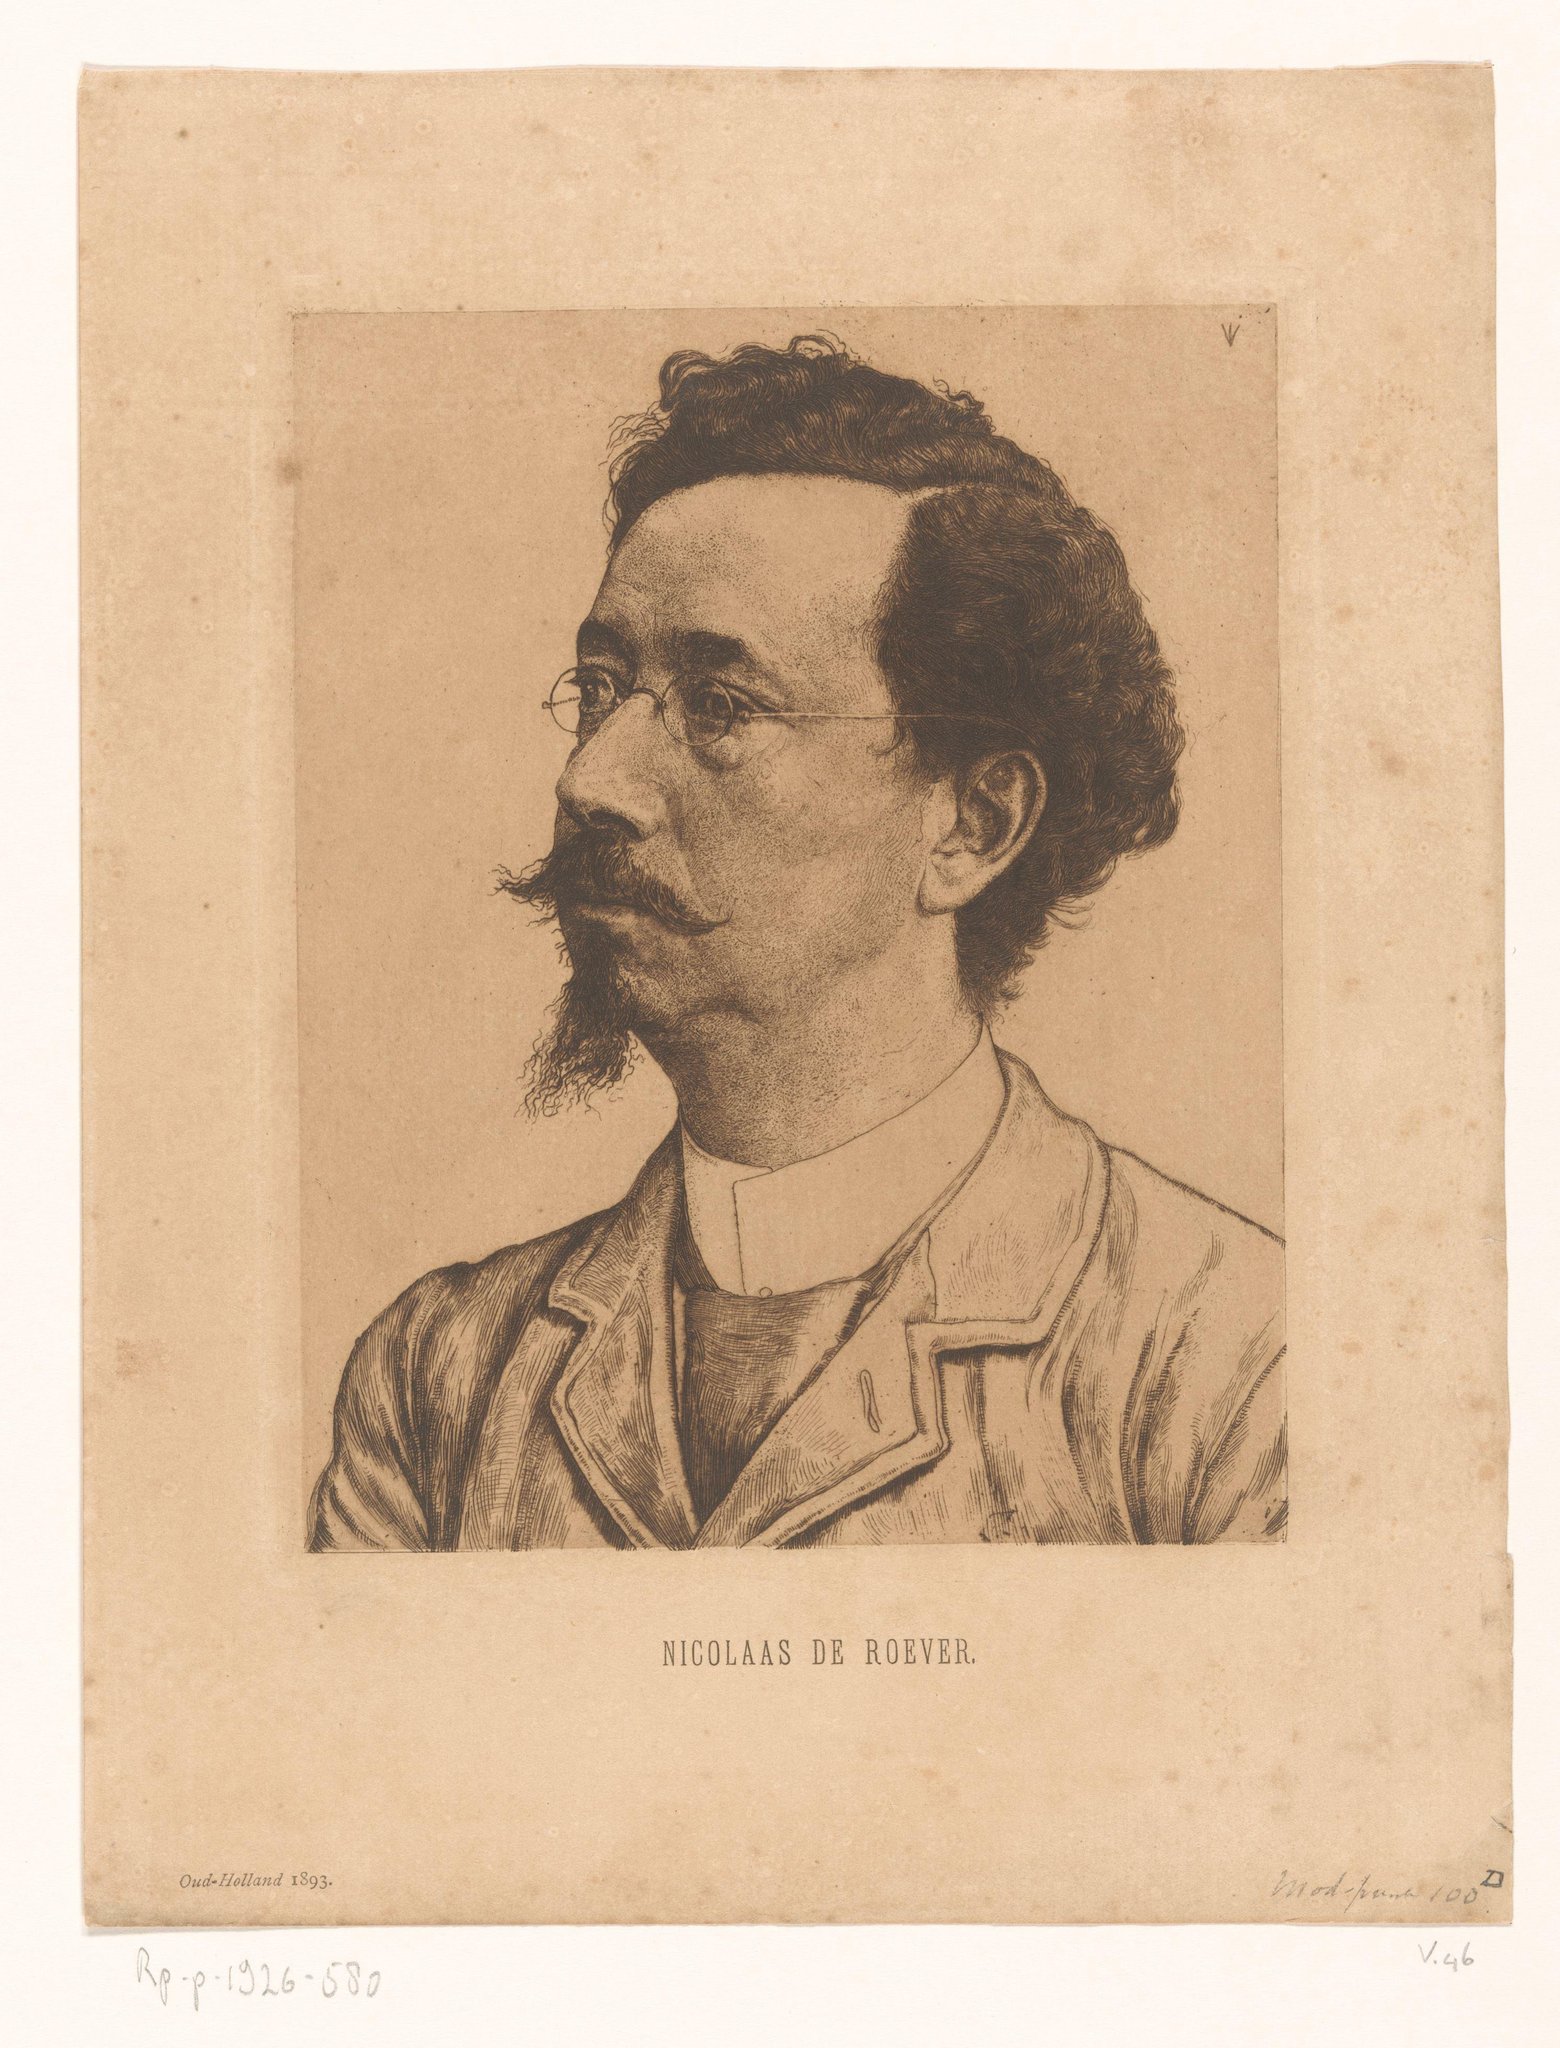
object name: print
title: Nicolaas de Roever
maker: jan veth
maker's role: designer, draughtsman, painter, print maker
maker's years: 1864-1925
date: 1893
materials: paper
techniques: etching, intaglio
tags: amsterdam, historical persons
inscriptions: collector's mark: Lugt 2228, inscription: ‘Oud-Holland 1893’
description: Prent in 1893 gebruikt als illustratie bij een artikel van Abraham Bredius in het tijdschrift Oud-Holland.